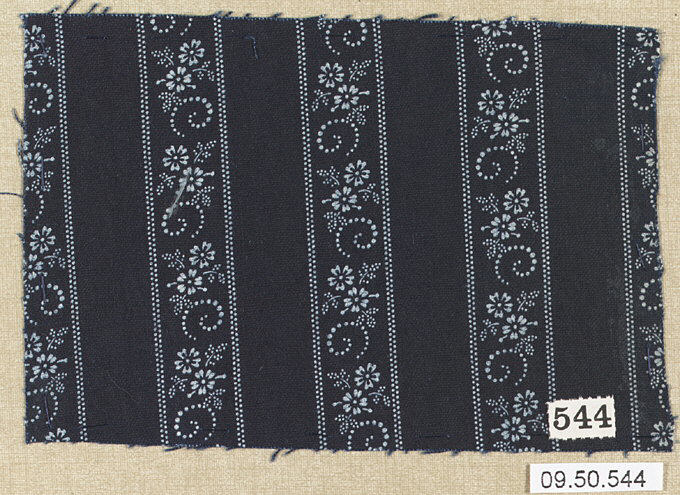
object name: piece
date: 1801-1900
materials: cotton